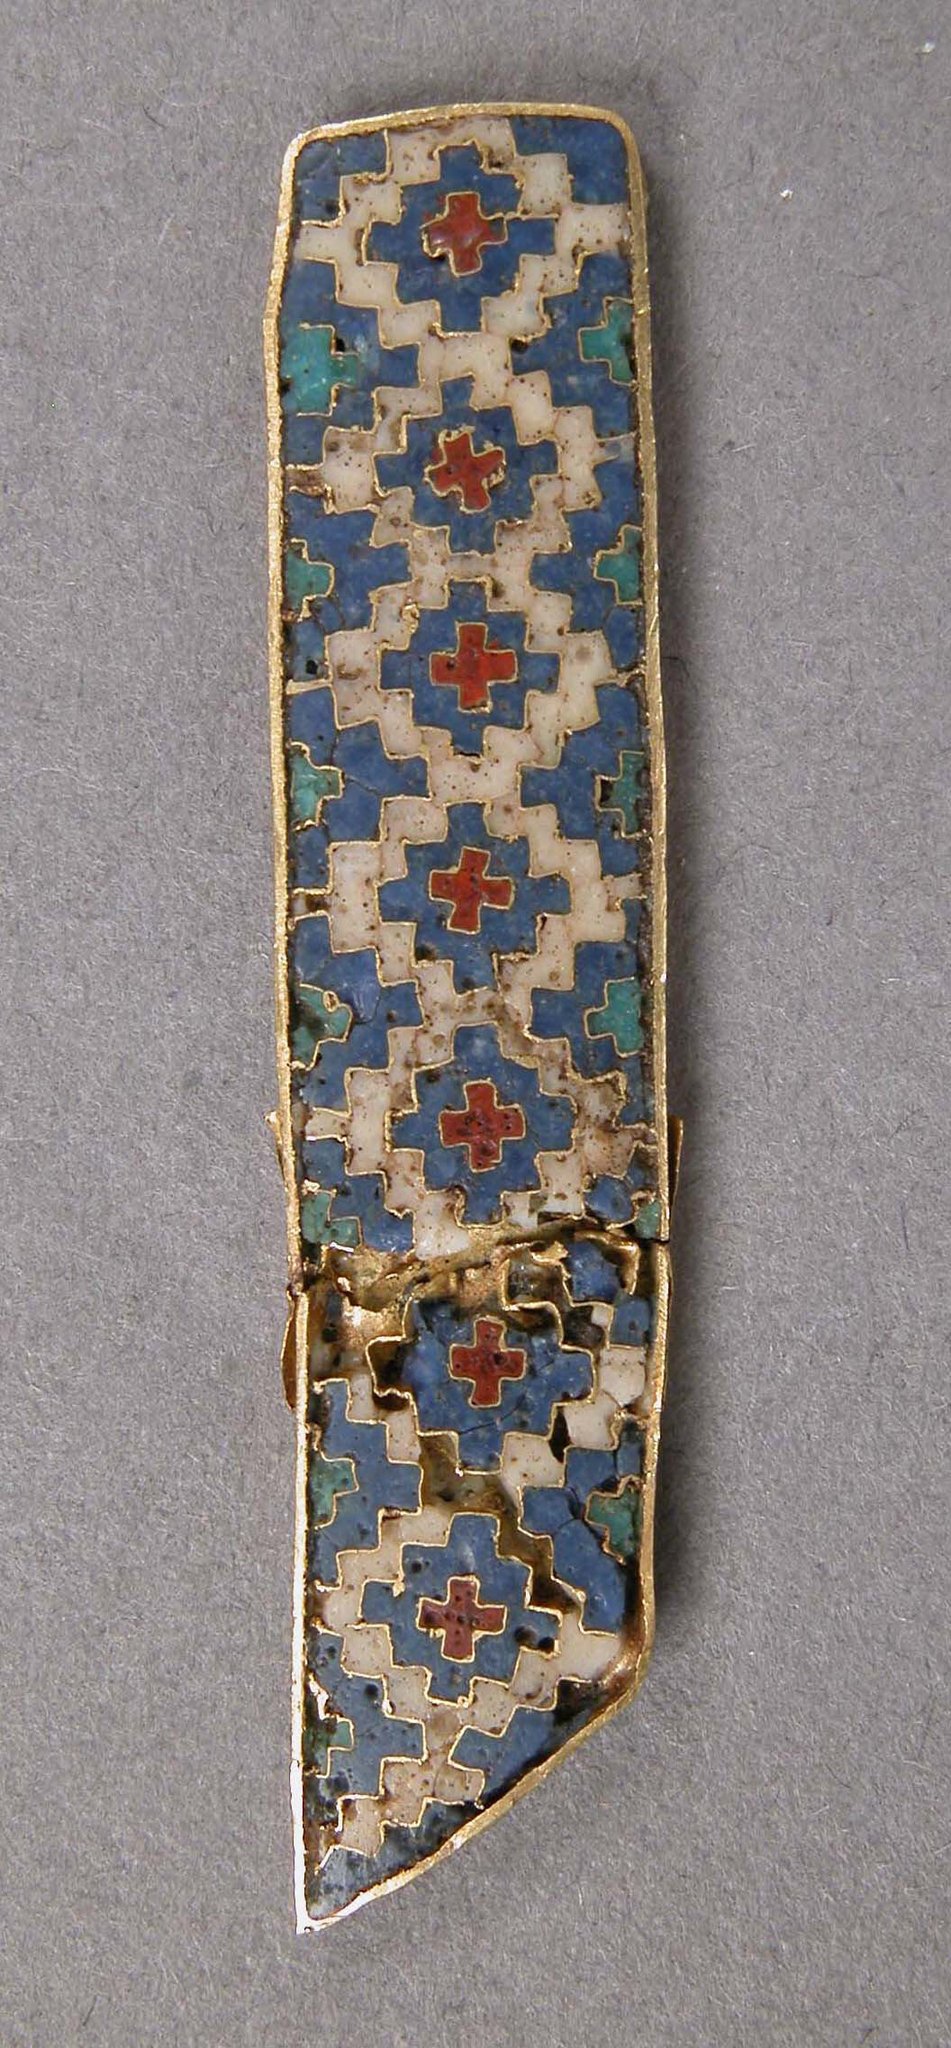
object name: border fragment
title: Element of a Border for an Icon Frame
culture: byzantine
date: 901-1000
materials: enamel, gold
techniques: enamel